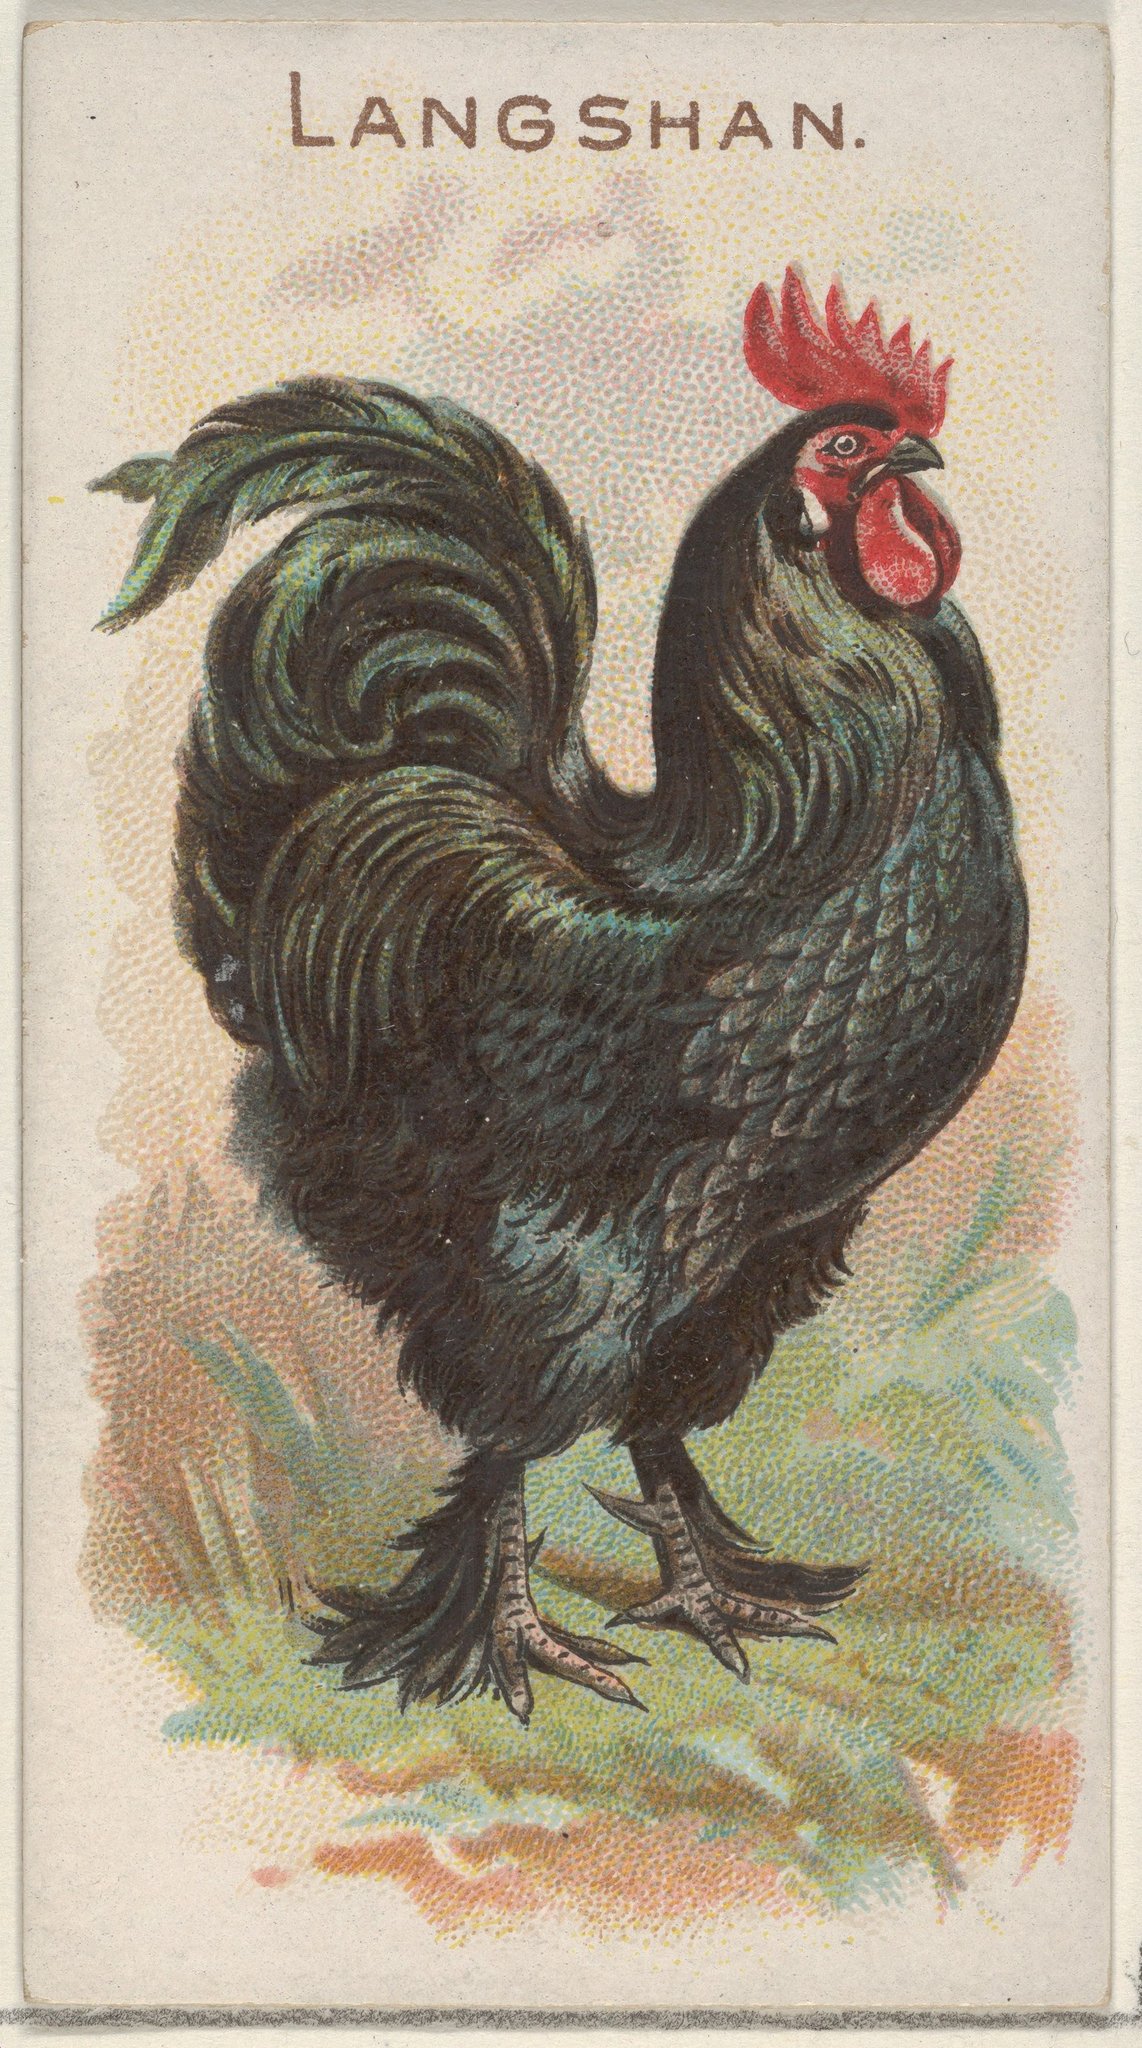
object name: print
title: Langshan, from the Prize and Game Chickens series (N20) for Allen & Ginter Cigarettes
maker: allen & ginter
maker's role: publisher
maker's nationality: american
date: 1891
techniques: color lithograph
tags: roosters